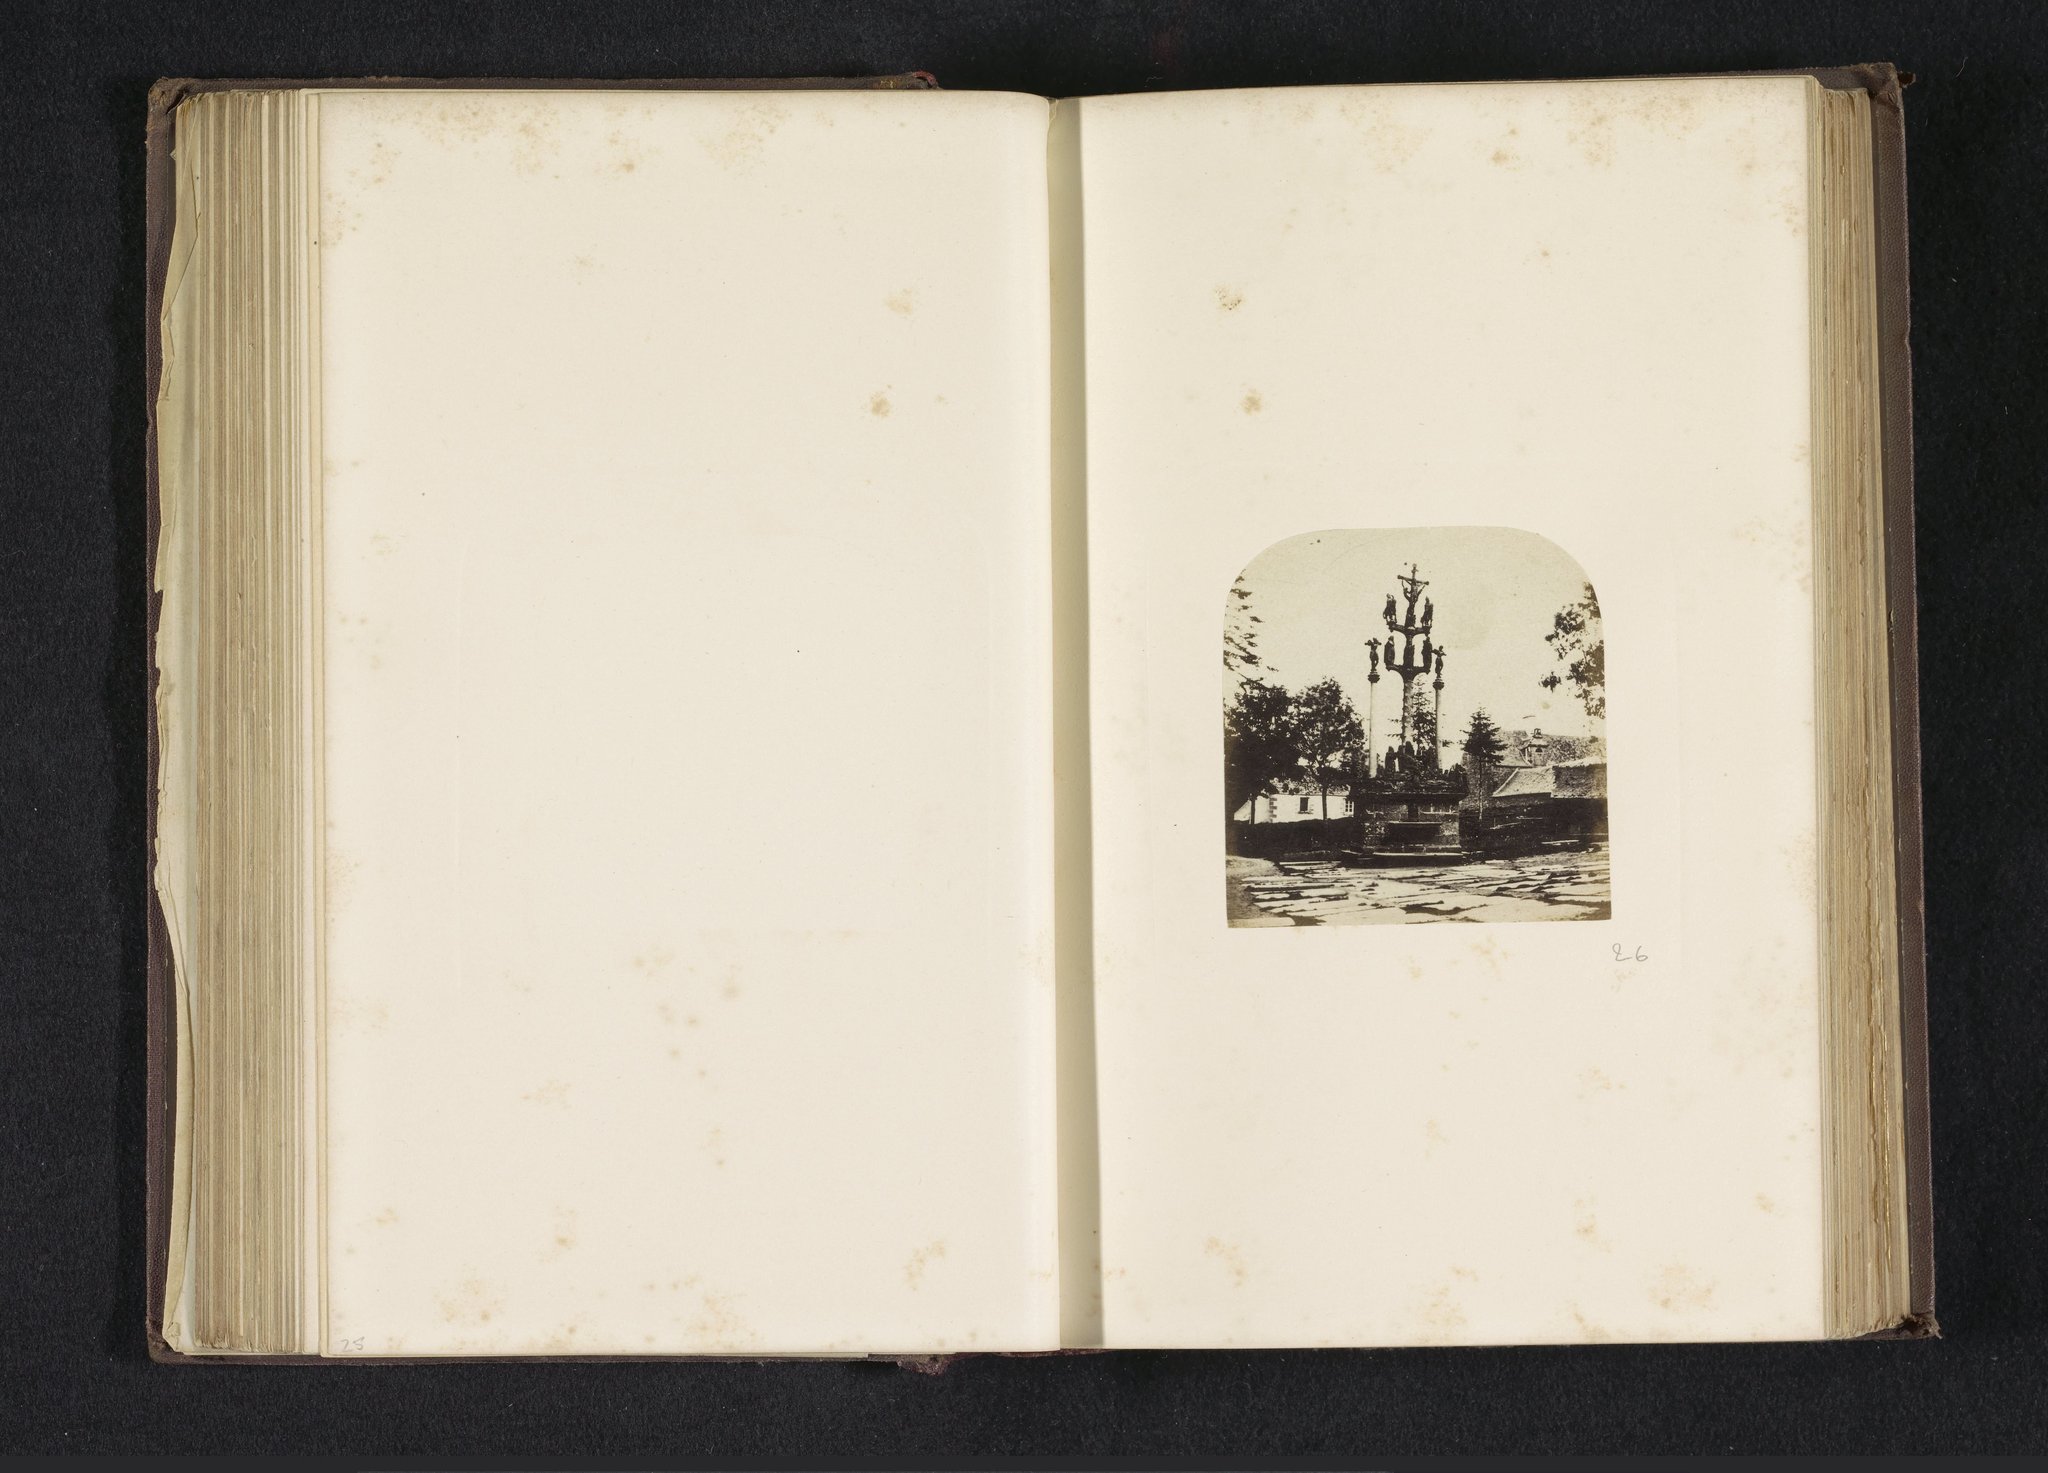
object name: page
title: Westzijde van het kerkhof (enclos paroissial) te Saint-Thégonnec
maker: taylor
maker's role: fotograaf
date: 1850-1859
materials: photographic support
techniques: albumen print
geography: saint-thégonnec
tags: piece of sculpture, reproduction of a piece of sculpture, churchyard, cemetery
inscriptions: number: ‘26’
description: Foto op derde ongenummerde pagina na pagina 118.